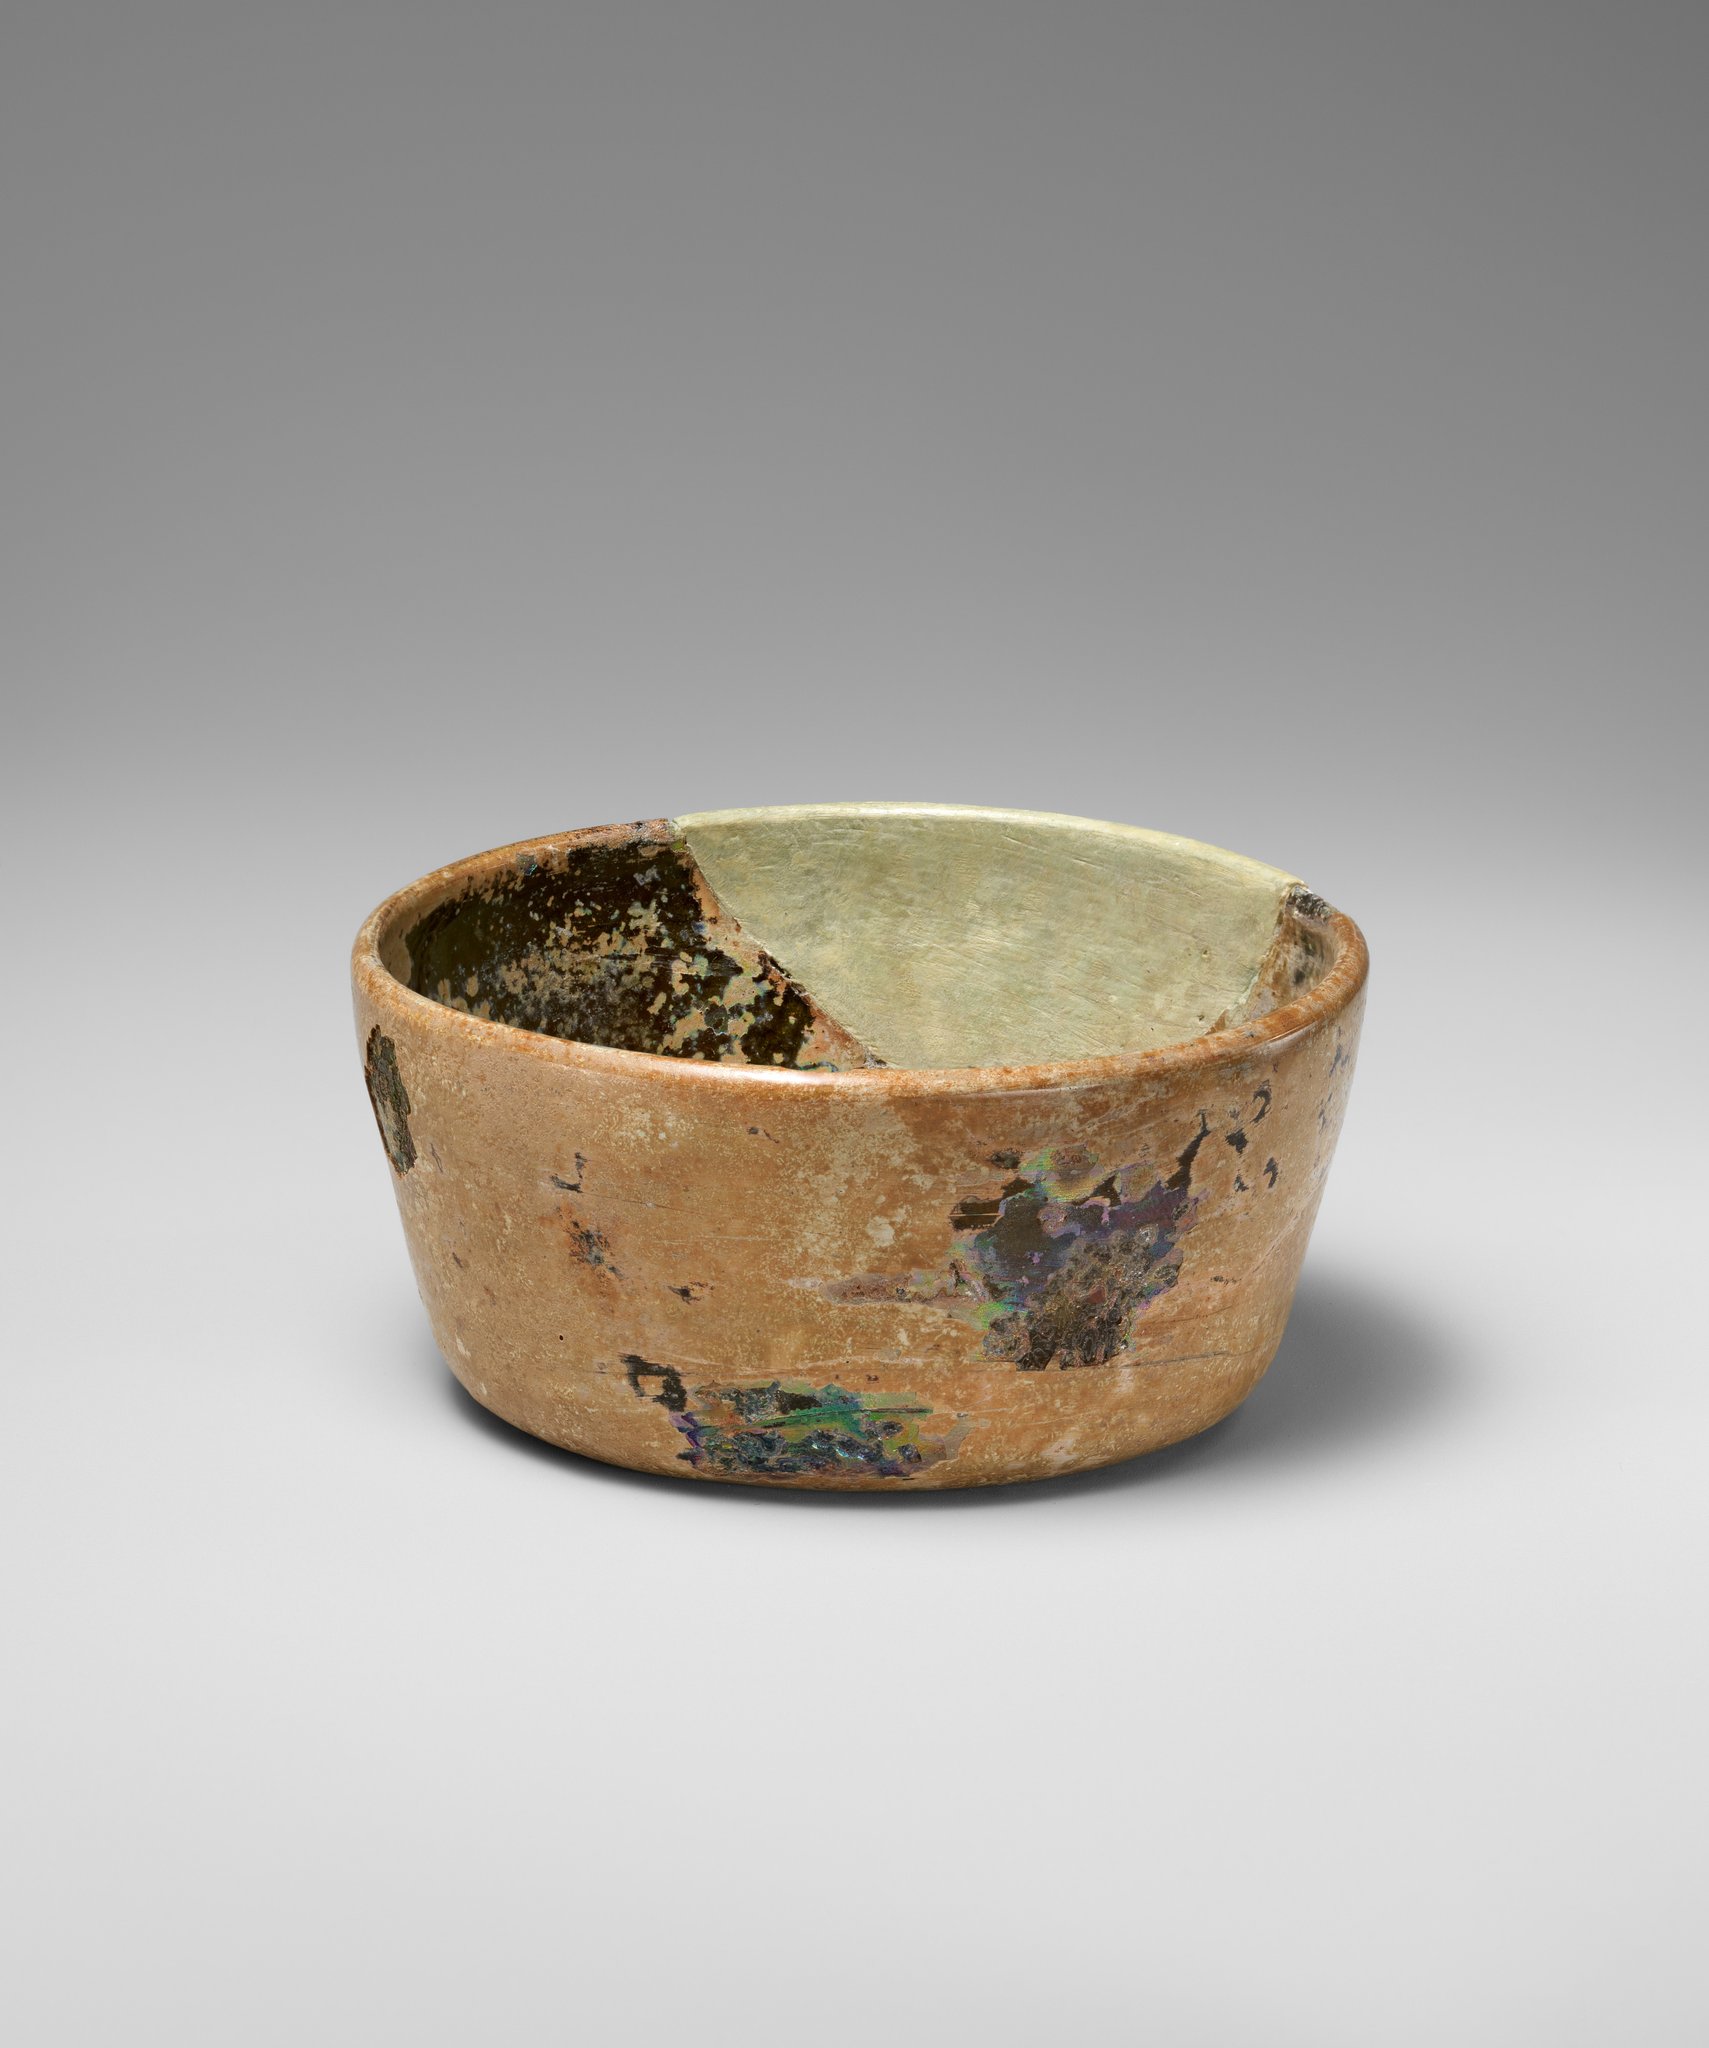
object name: dish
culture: sasanian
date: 201-700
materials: glass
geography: mesopotamia